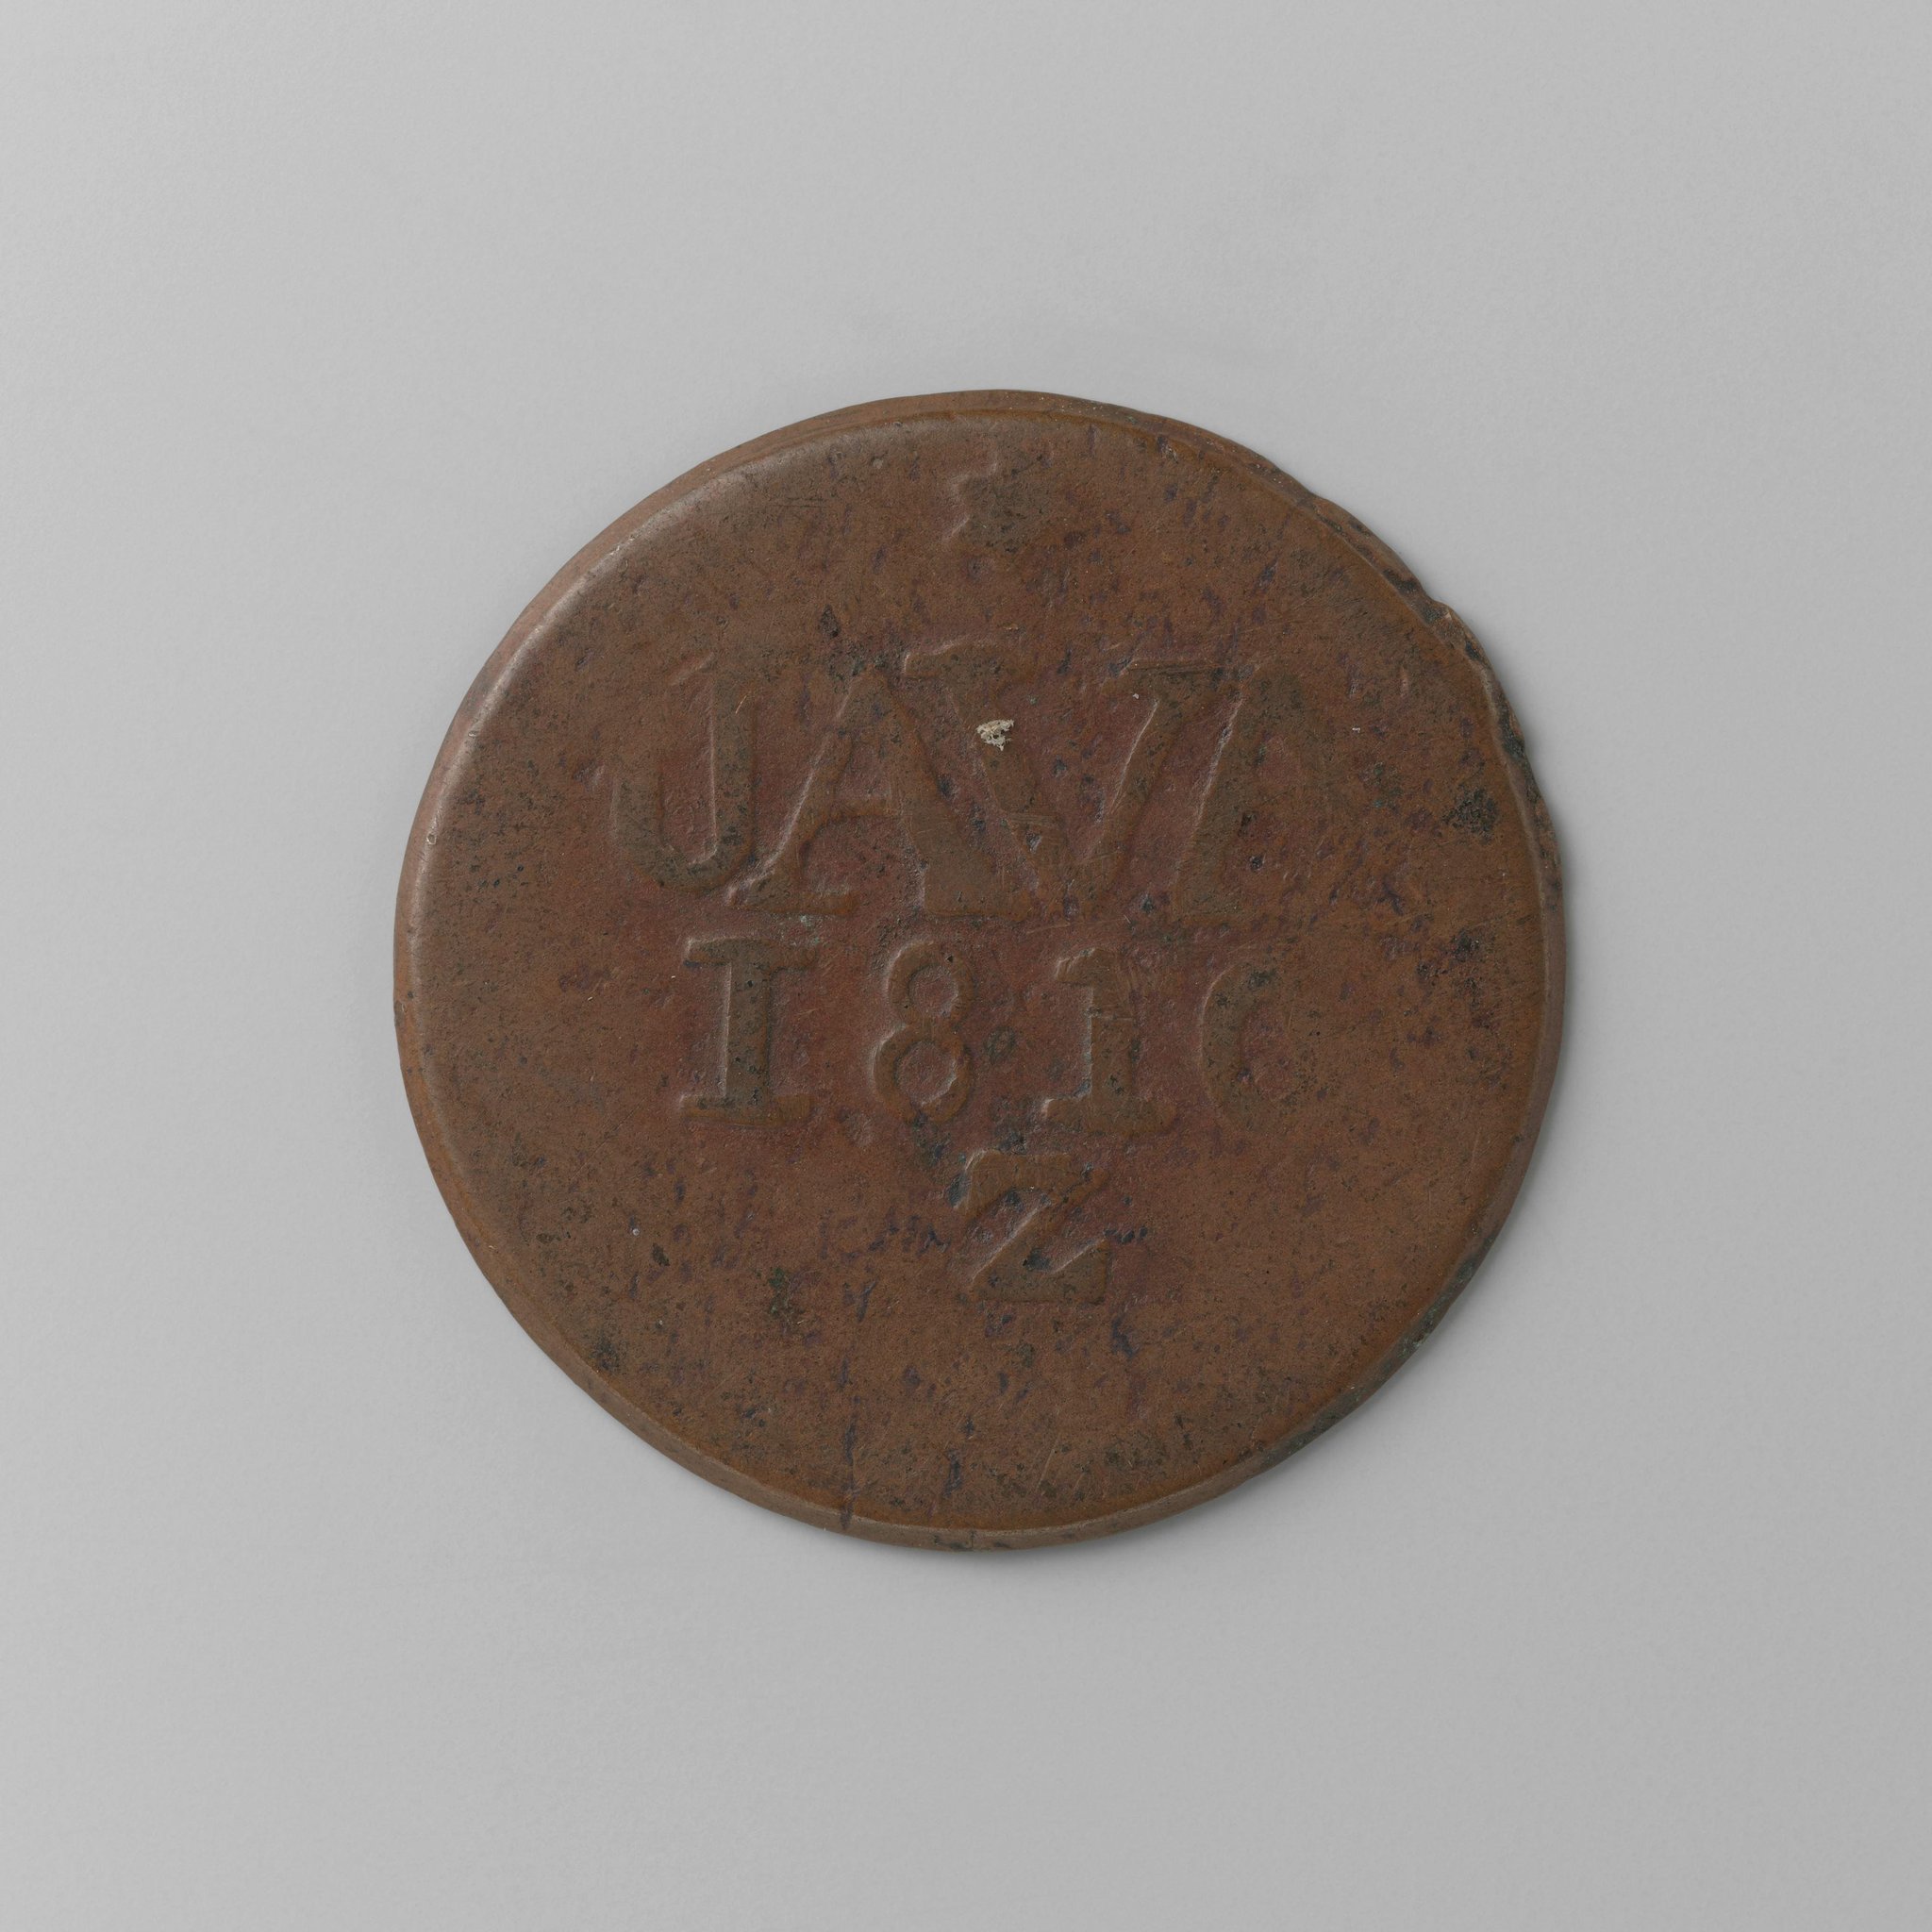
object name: coin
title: Nederlands Indië, duit Java,1810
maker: louis napoleon (king of holland)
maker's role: koning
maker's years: 1778-1846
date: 1810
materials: copper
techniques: striking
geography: surabaya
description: Koperen munt. Voorzijde: initialen L en N van Lodewijk Napoleon. Daarboven muntteken. Keerzijde: eenregelig opschrift, waaronder jaartal. Boven opschrift muntteken en onder jaartal muntmeesterteken Z [=muntmeester Zwekkert].